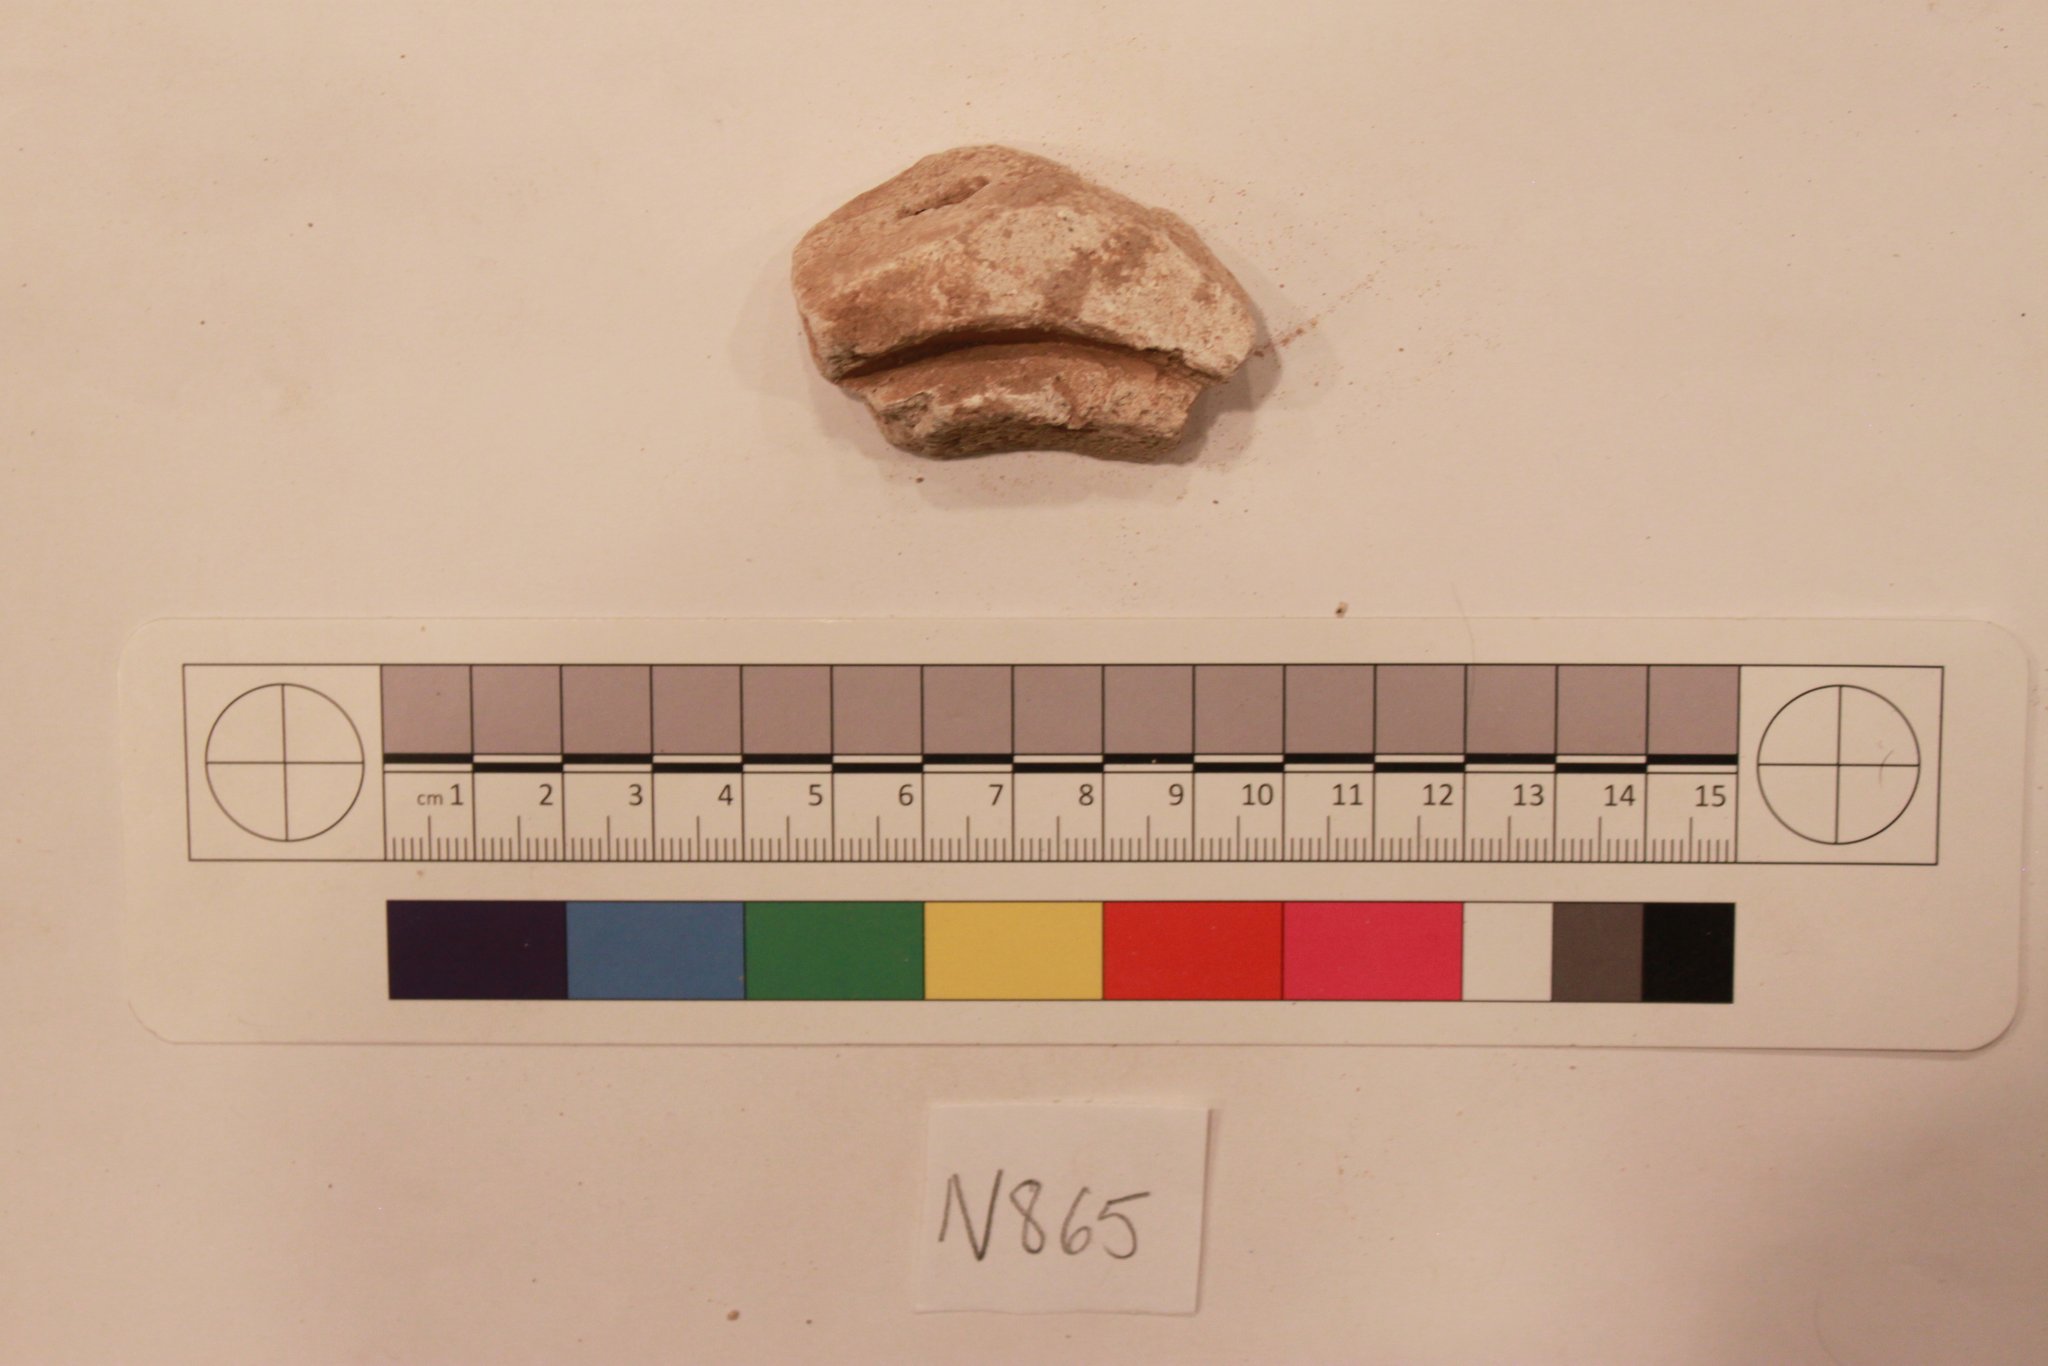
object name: fragment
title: Stucco Fragment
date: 701-1200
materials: plaster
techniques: carving, painting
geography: iran